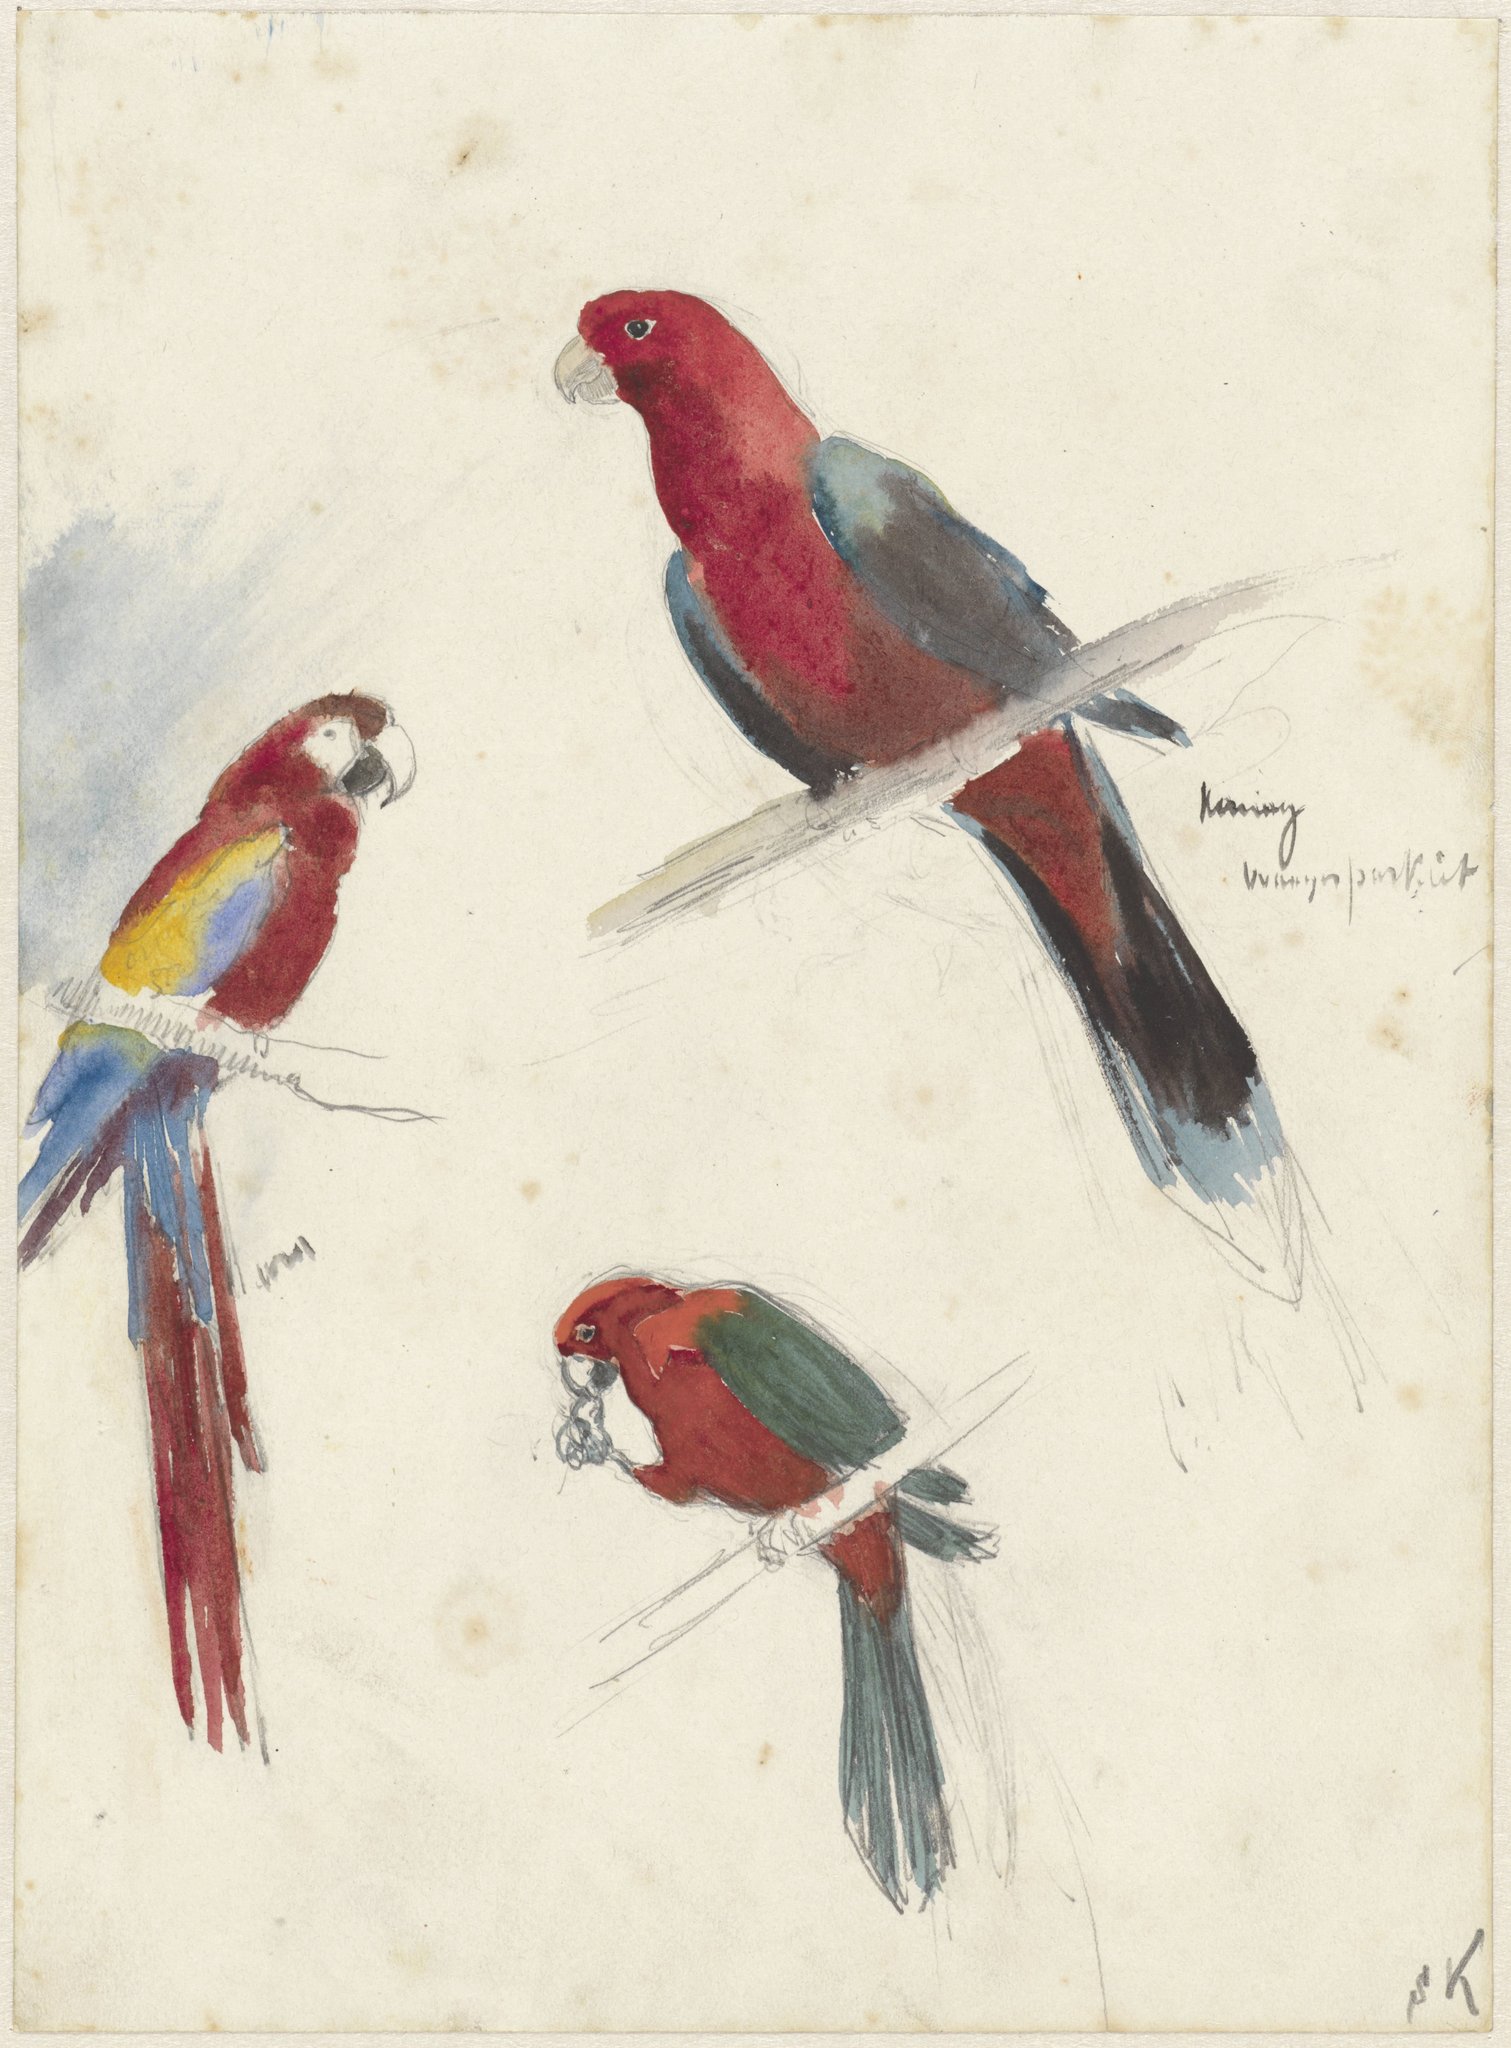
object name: drawing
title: Studies van papegaaien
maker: anna maria kruijff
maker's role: draughtsman, print maker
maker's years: 1870-1946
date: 1880-1946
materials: paper, pencil, watercolor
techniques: brush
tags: ornamental birds: parrot